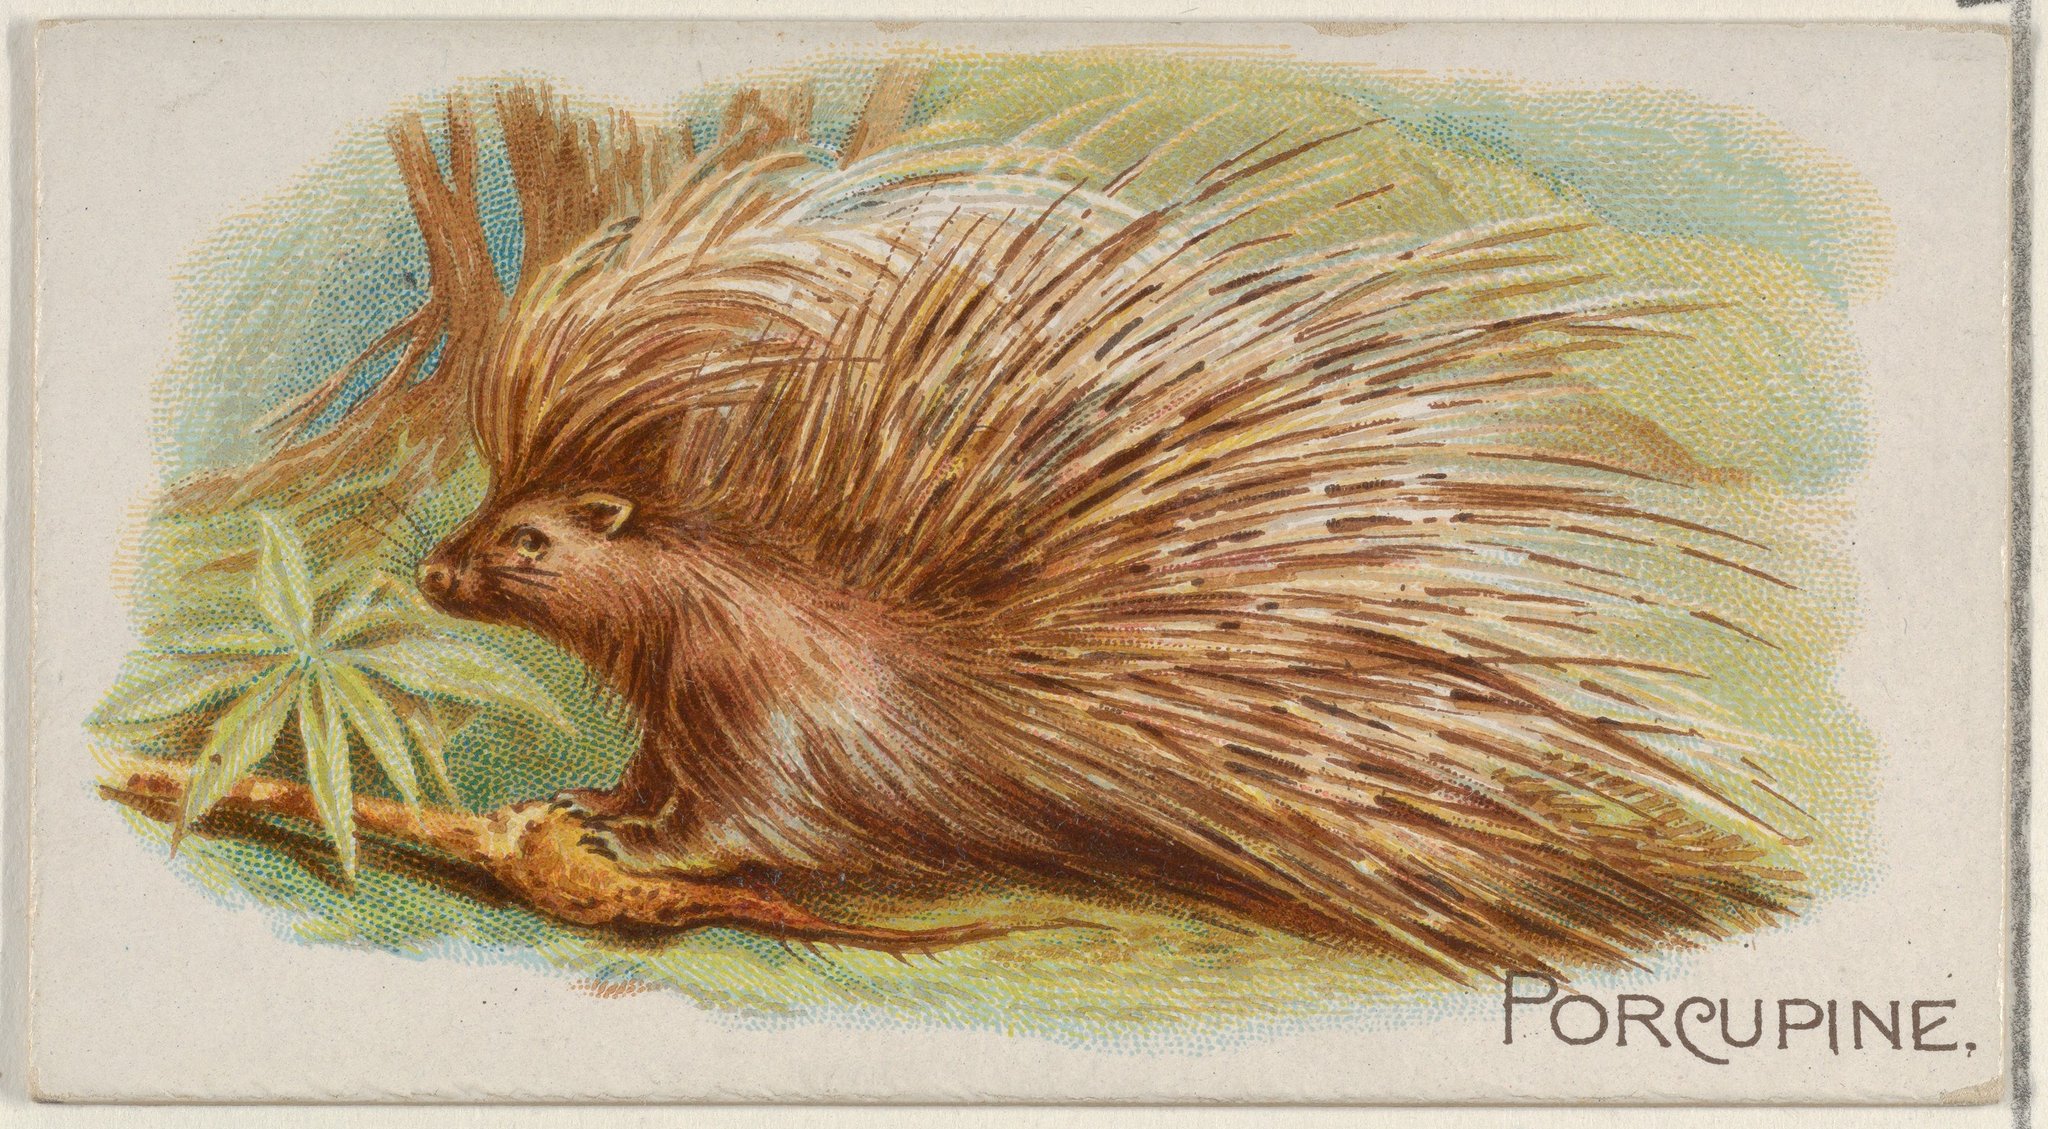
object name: print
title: Porcupine, from the Quadrupeds series (N21) for Allen & Ginter Cigarettes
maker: allen & ginter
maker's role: publisher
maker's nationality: american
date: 1890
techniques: color lithograph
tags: animals